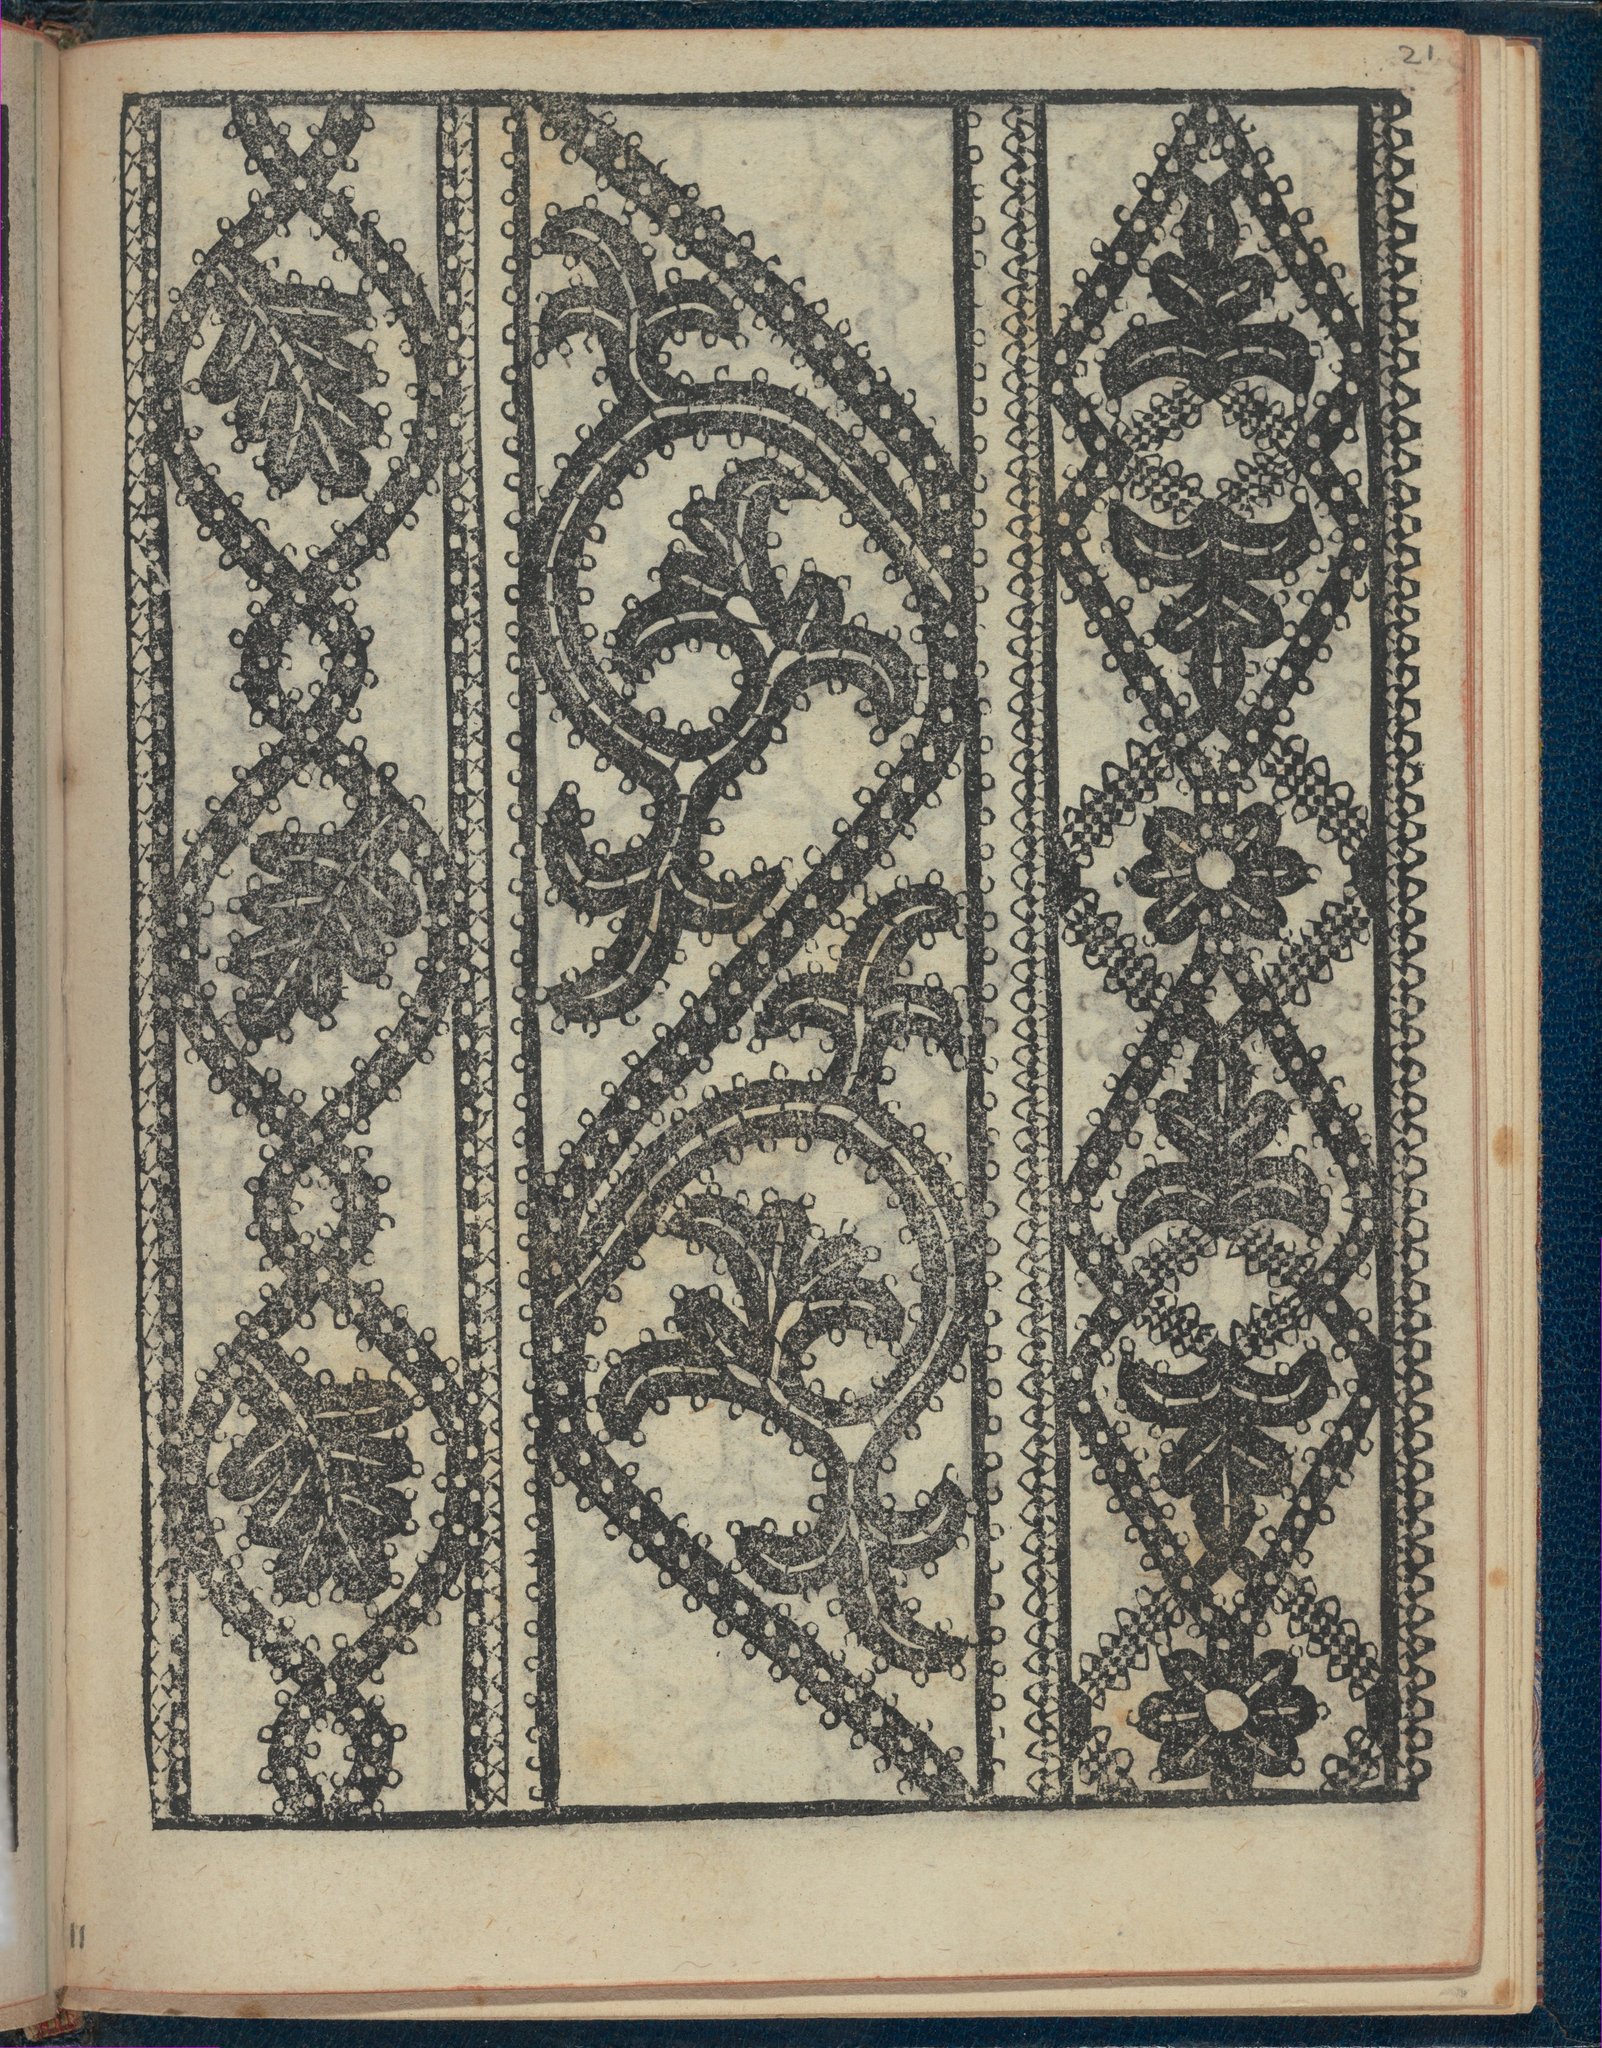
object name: book print ornament architecture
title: Le Pompe: Opera Nova, page 11 (recto)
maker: giovanni battista & marchio sessa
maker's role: publisher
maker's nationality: italian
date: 1557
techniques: woodcut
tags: ornament